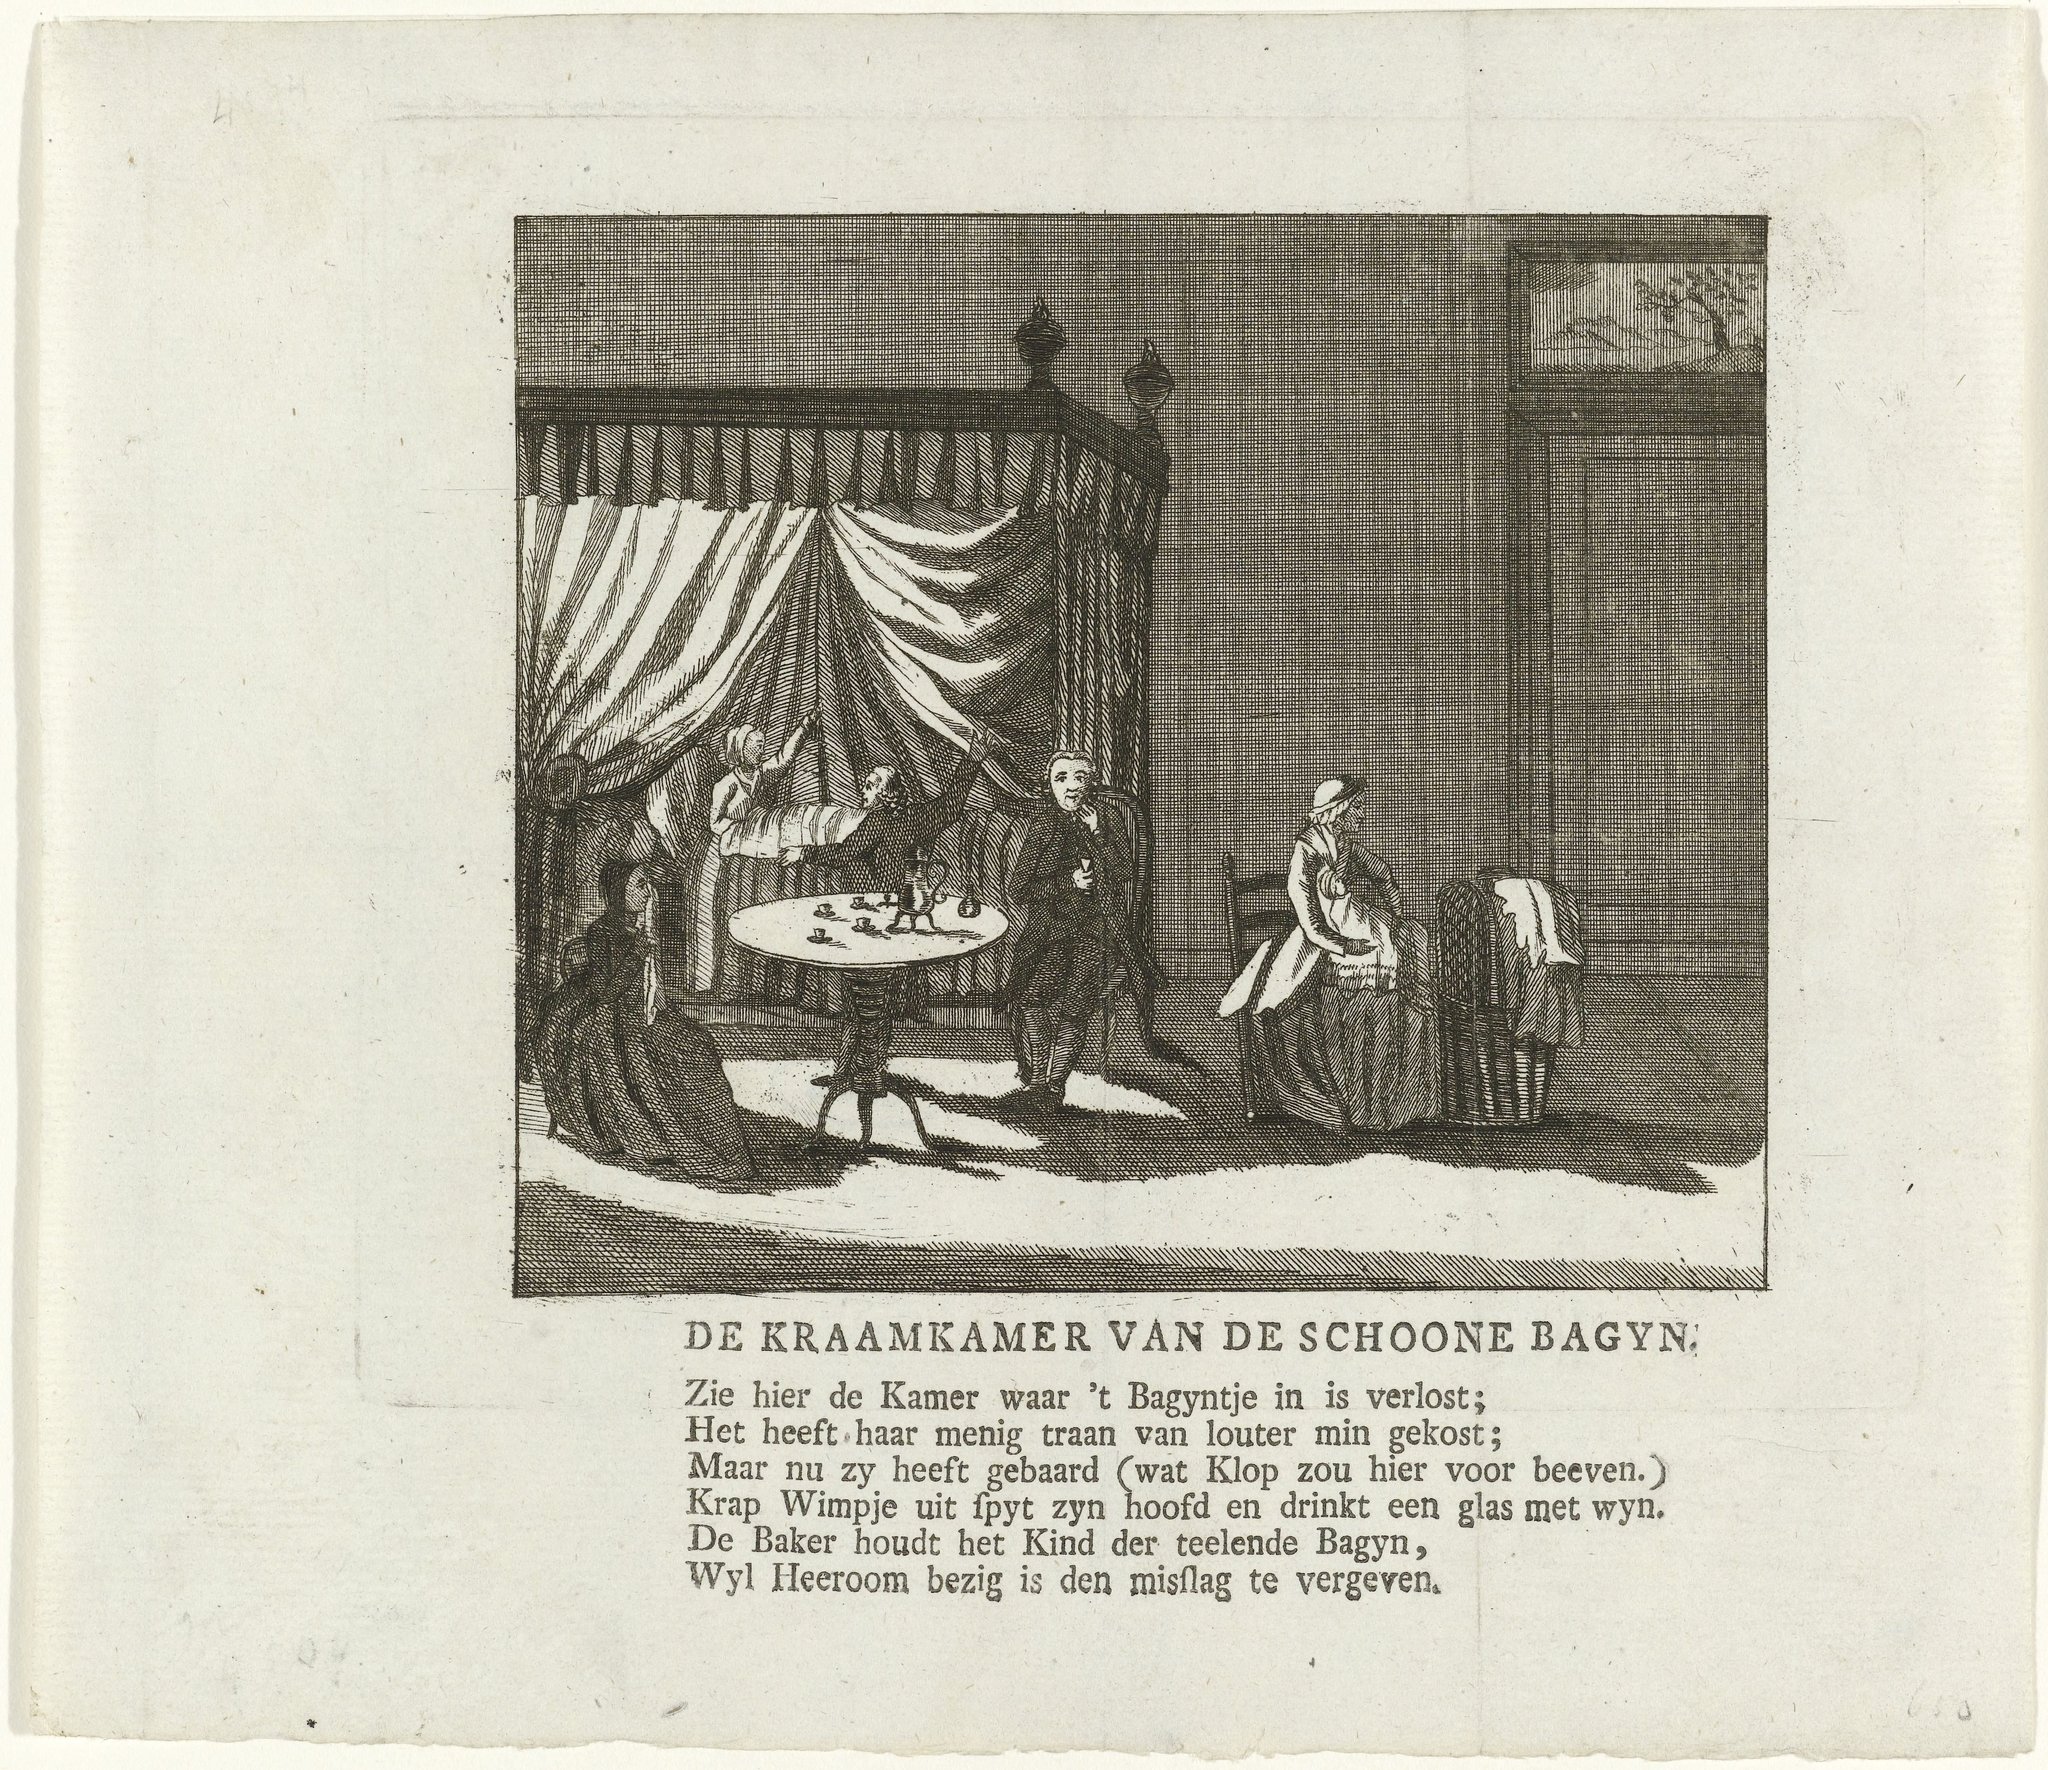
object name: print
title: Spotprent op Willem V en zijn maitresse de freule van Lynden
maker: Anonymous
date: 1782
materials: paper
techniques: etching, letterpress printing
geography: northern netherlands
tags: the hague, william v (prince of orange), lying-in room, patriots (1780-1795)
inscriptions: collector's mark: Lugt 2228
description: Kraamkamer waarin een vrouw net is bevallen, rechts neemt een baker het kind op de schoot. Aan een tafel drinkt een man een glas wijn. Een pastoor schenkt de bagijn vergiffenis. Te interpreteren als een spotprent op prins Willem V en zijn maîtresse Constance van Lynden, ca. 1782. Gedrukt op het blad een zesregelig vers.